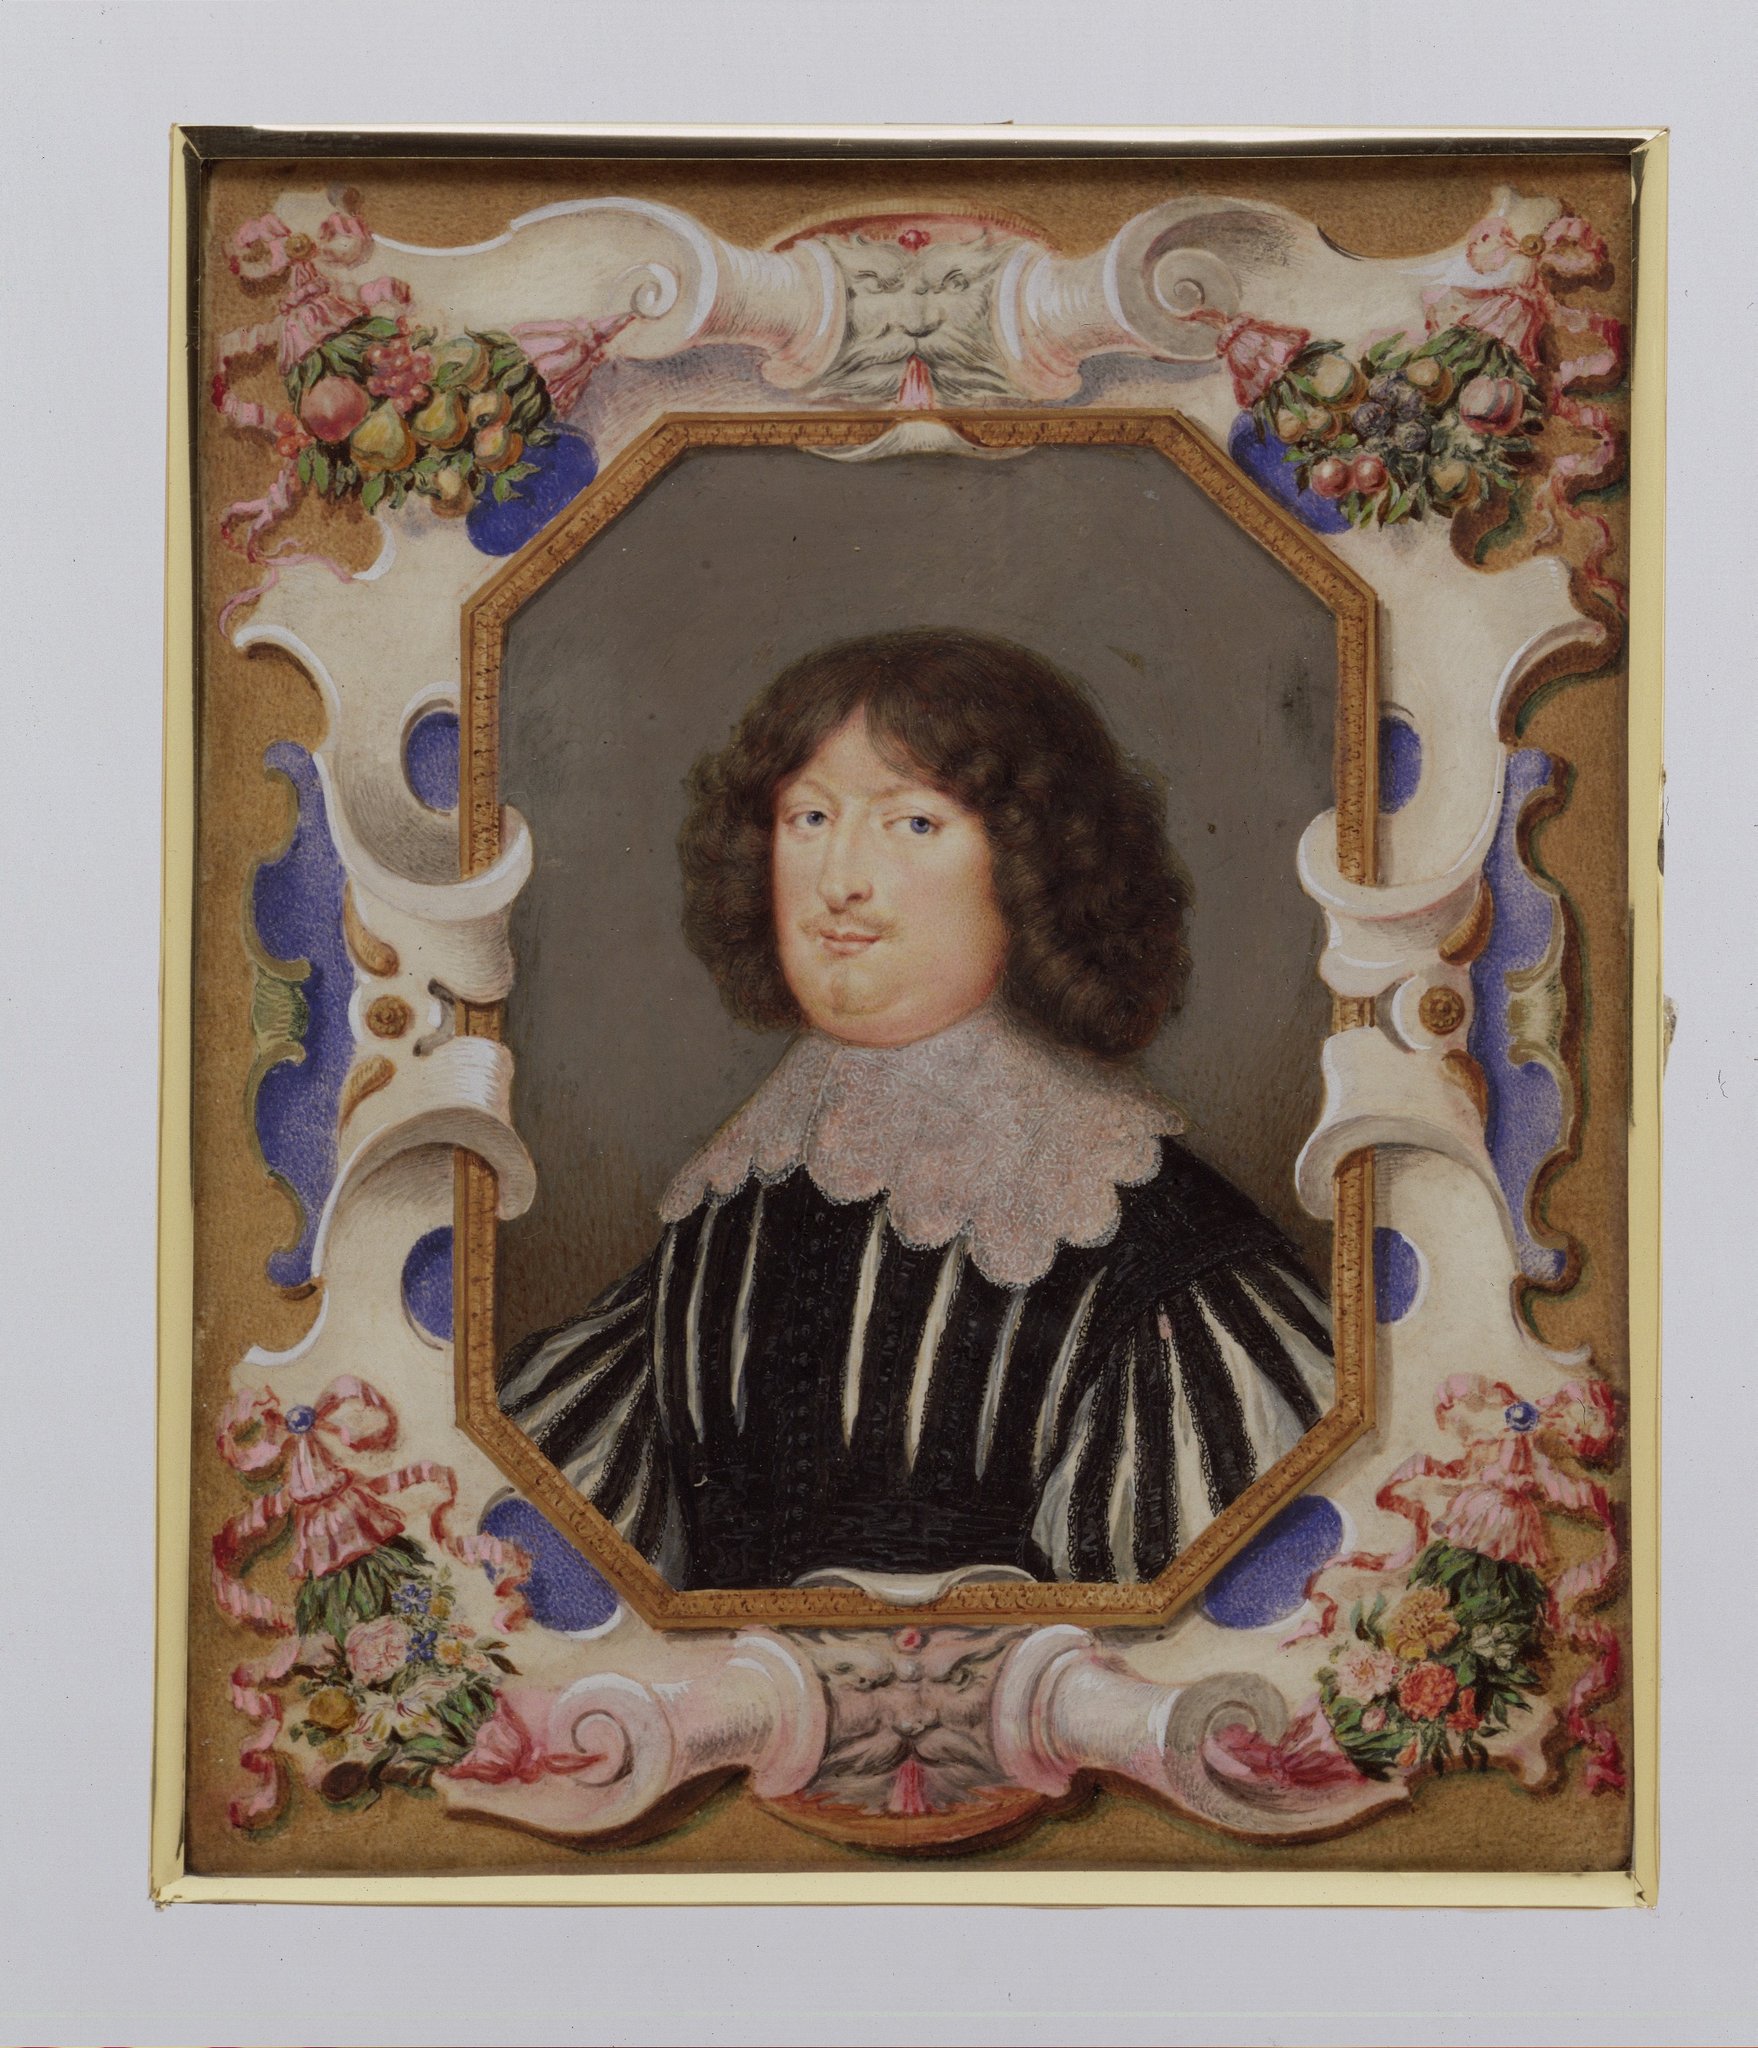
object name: painting, miniature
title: Portrait of a Man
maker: jacques saillant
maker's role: artist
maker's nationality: french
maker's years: 1620-1638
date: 1628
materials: parchment, wood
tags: men,portraits